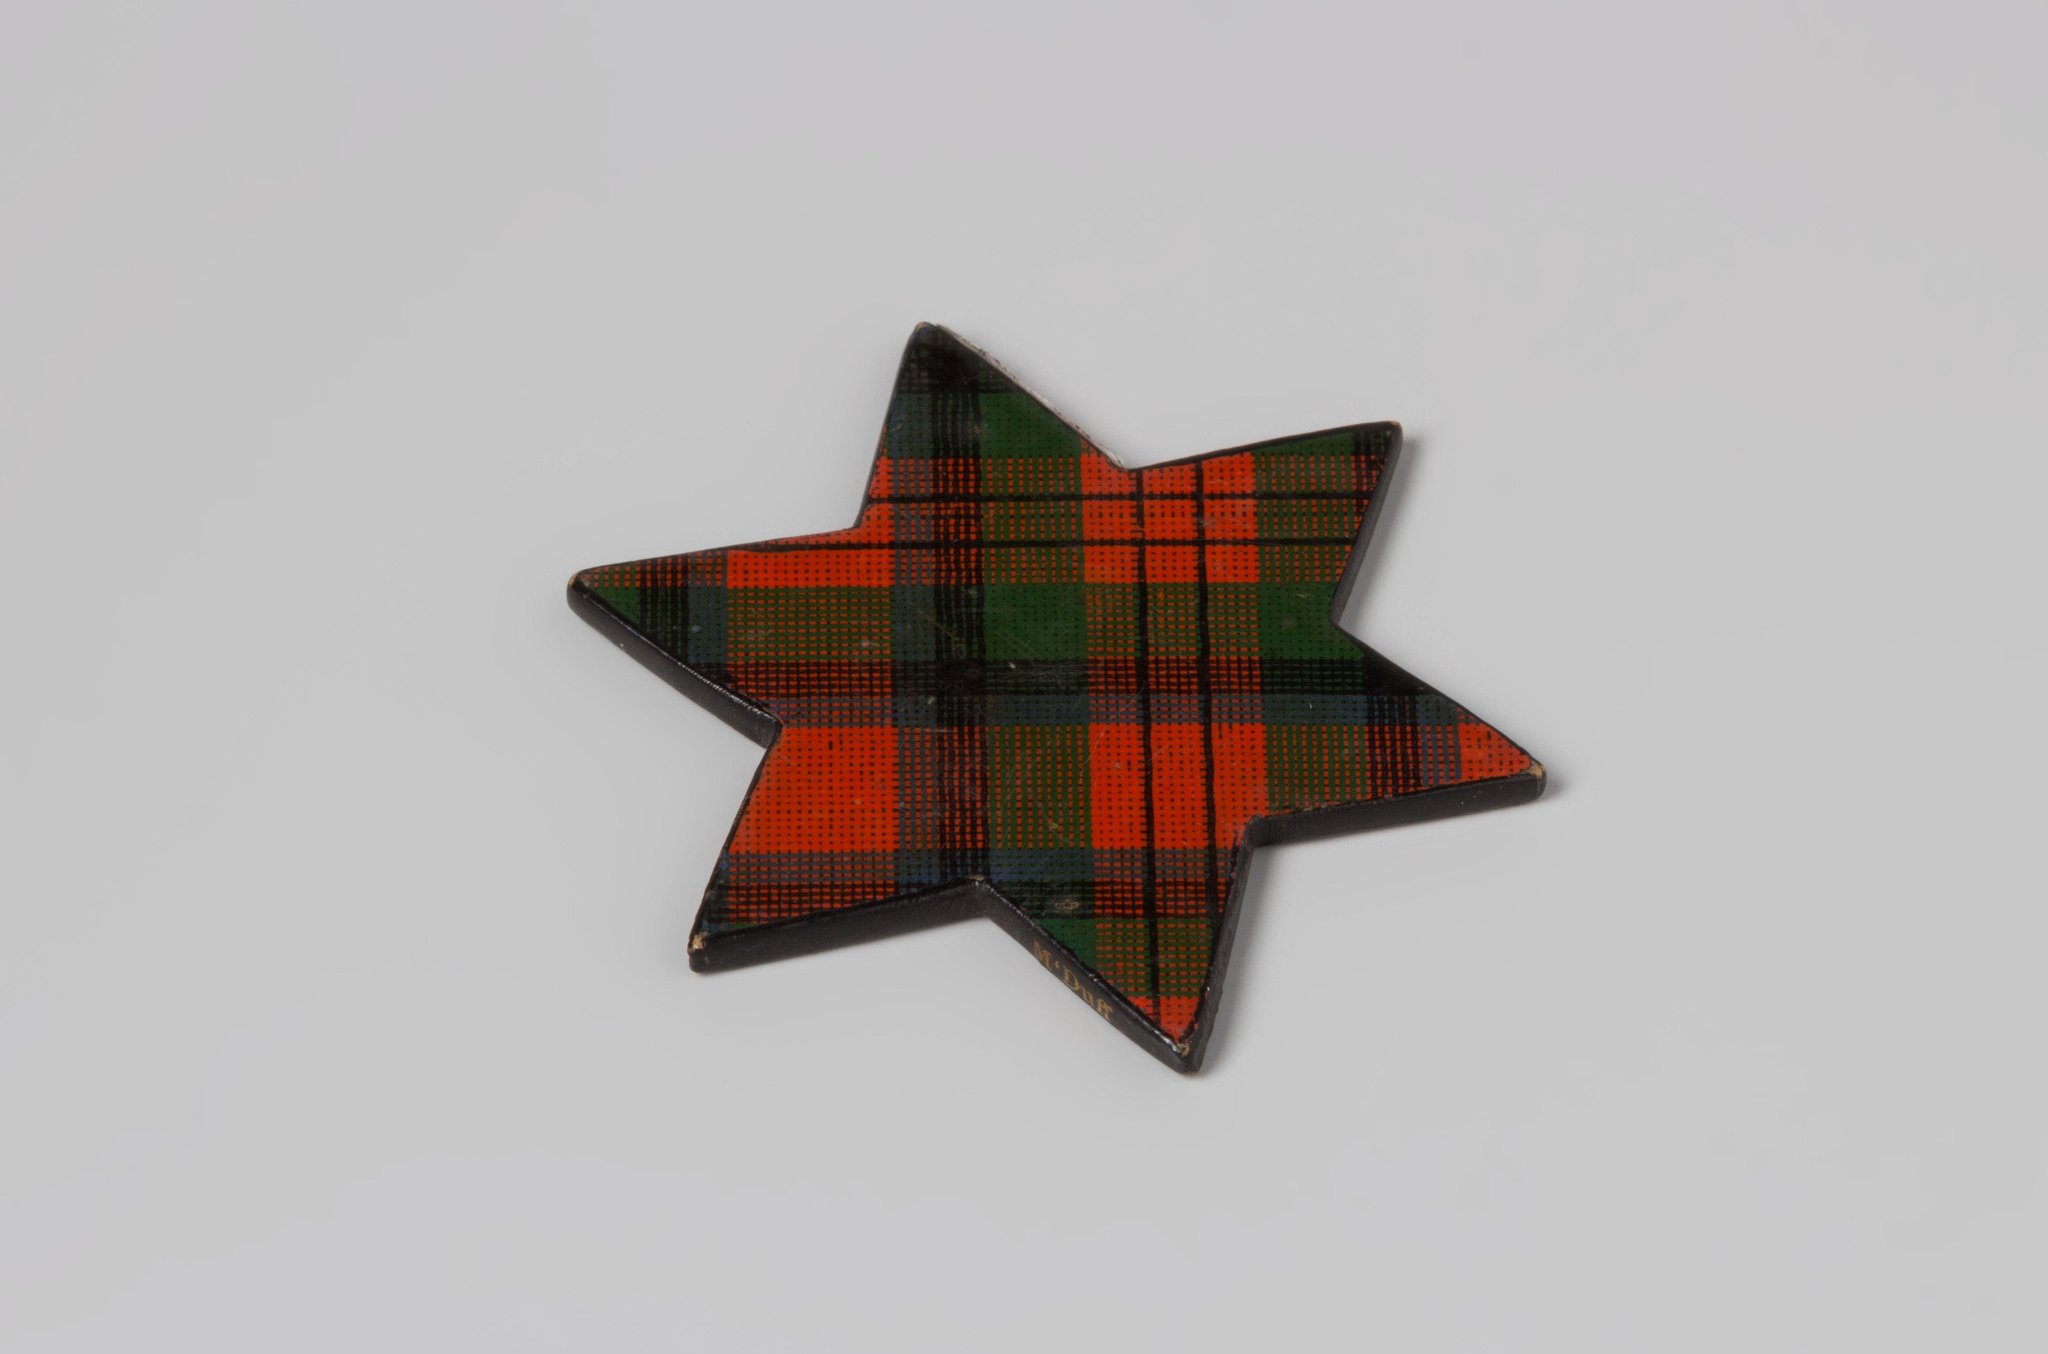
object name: textile working equipment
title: Garenwinder van tartanware, stervormig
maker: Anonymous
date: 1875-1900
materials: lacquer, paper, wood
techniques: cutting, lacquer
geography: scotland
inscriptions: name: ‘'M'Duff'’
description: Een garenwinder in tartanware. Een zespuntige ster met Schotse ruit in groen, rood, grijs en zwart. Clan: 'M'Duff', in goud letters opgebracht.